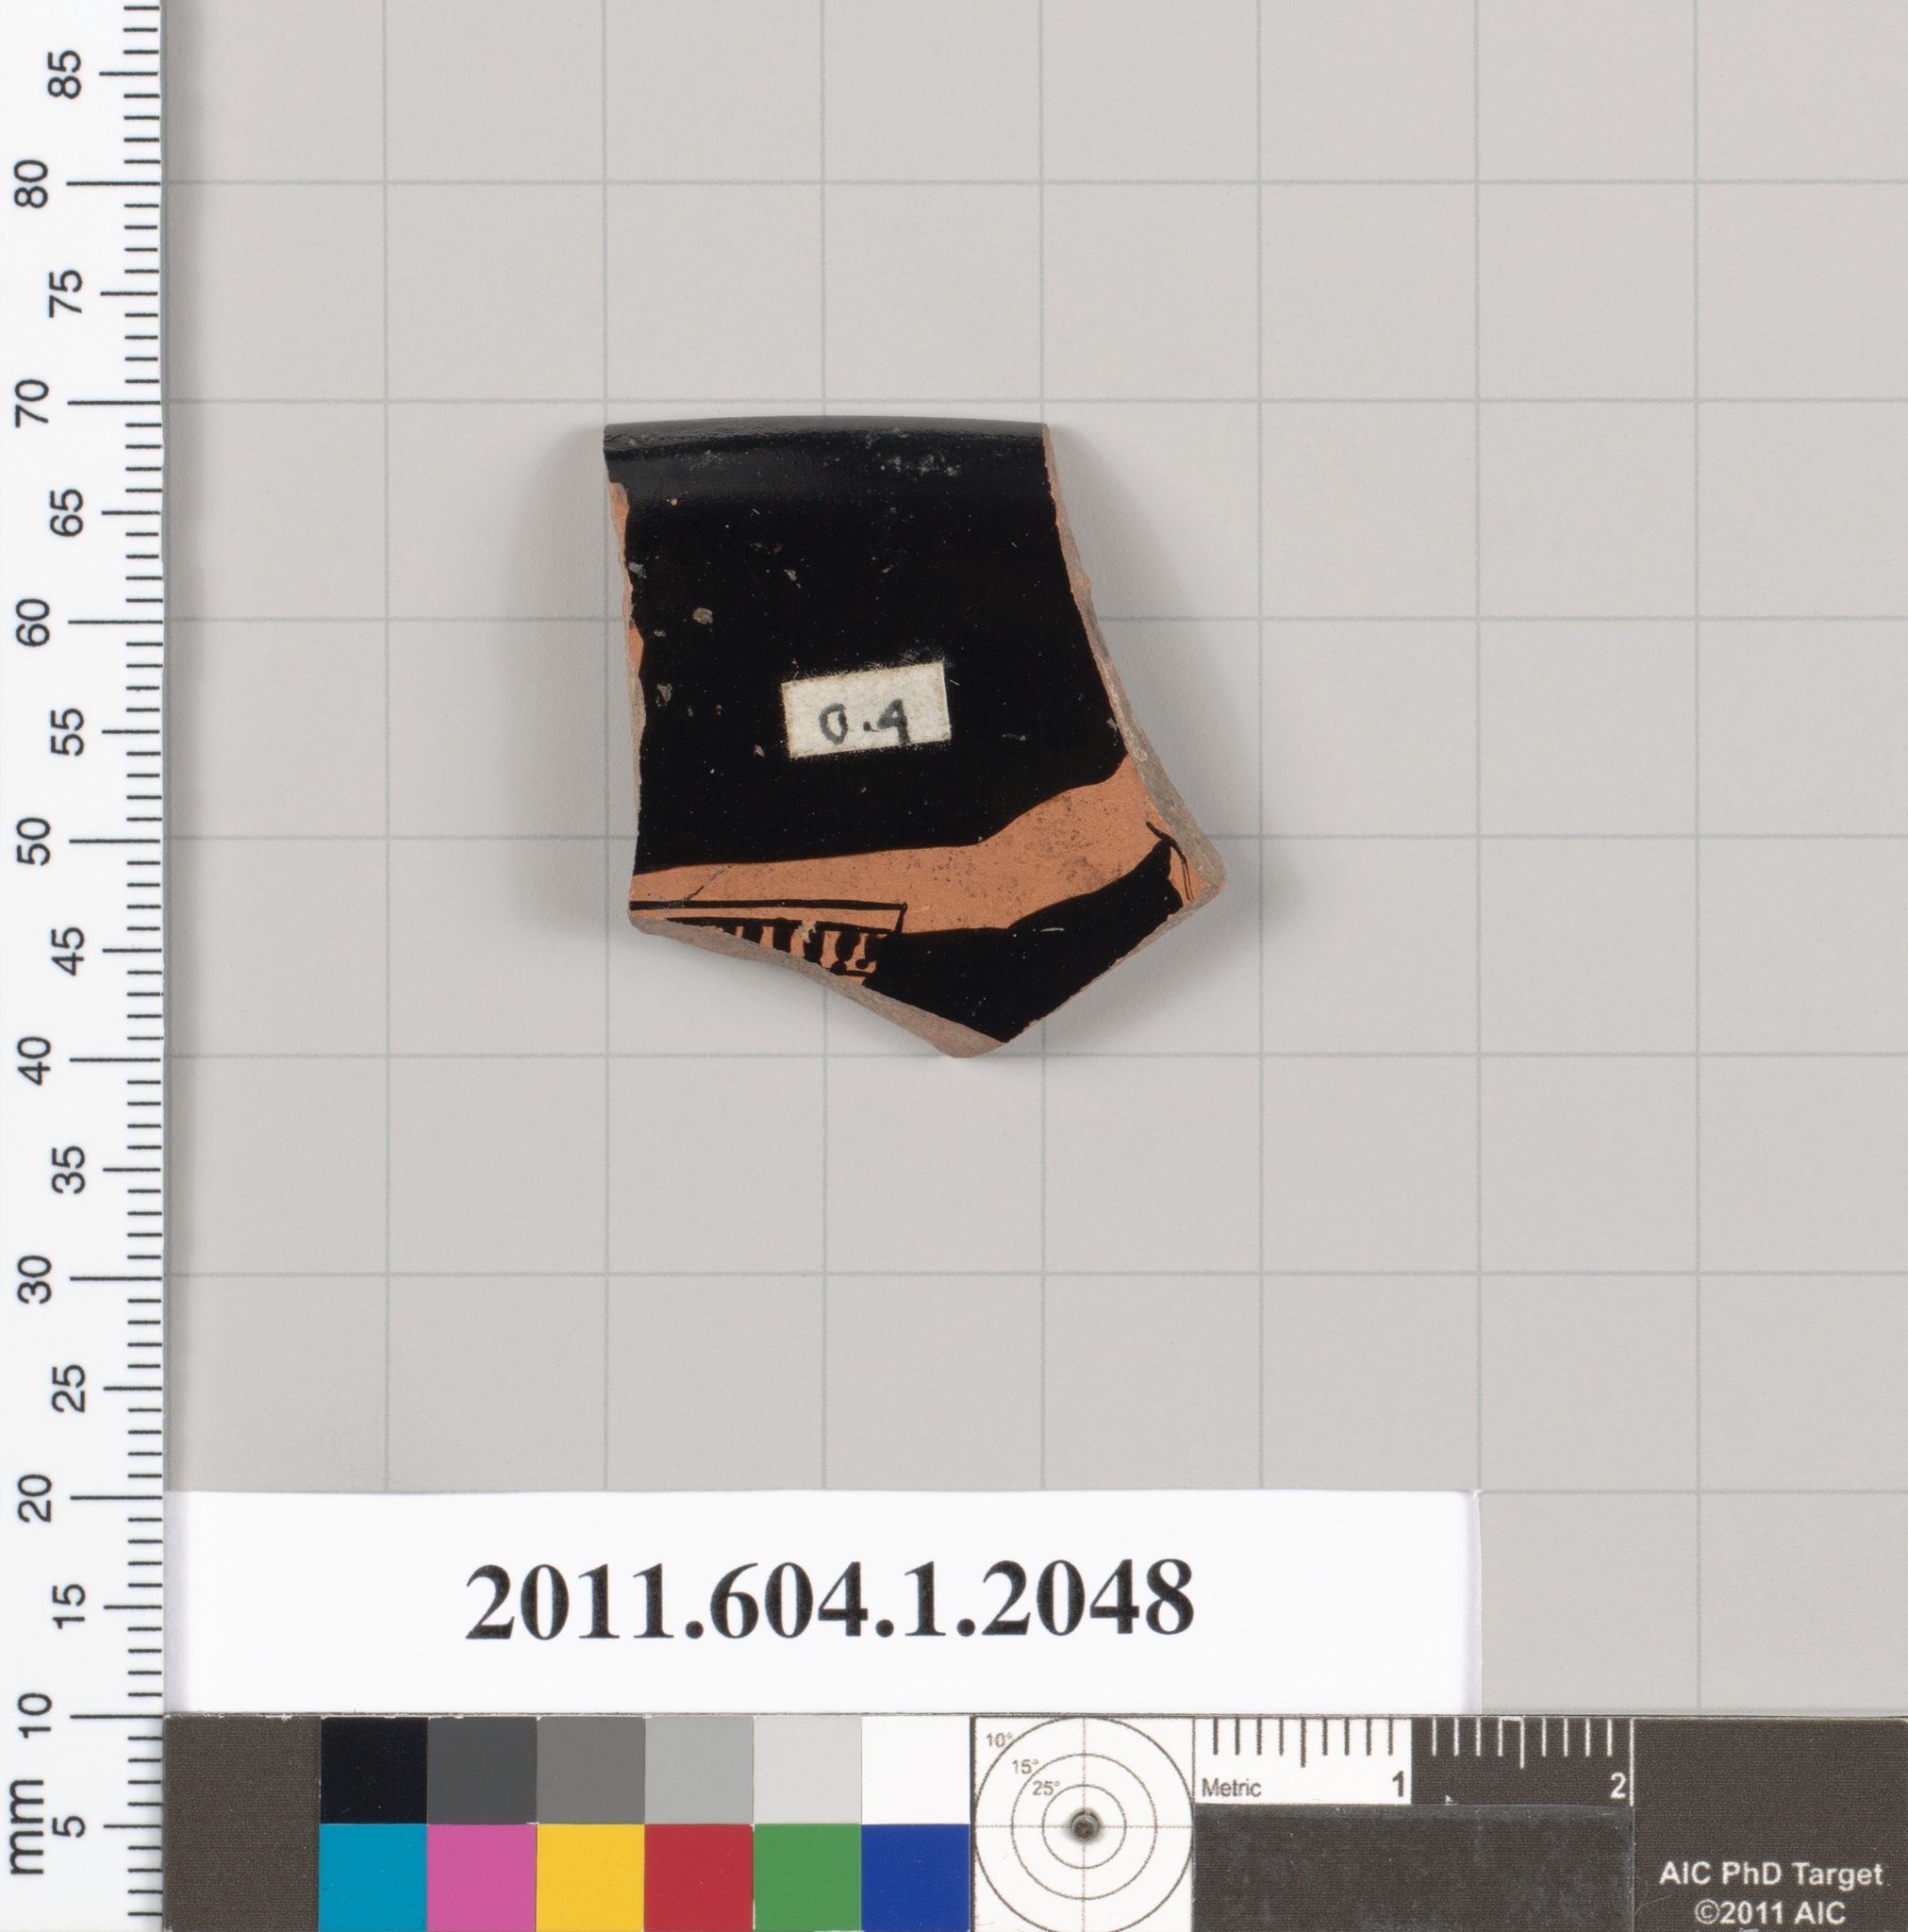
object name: kylix fragment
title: Terracotta rim fragment of a kylix (drinking cup)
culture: greek, attic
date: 475-451 BCE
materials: terracotta